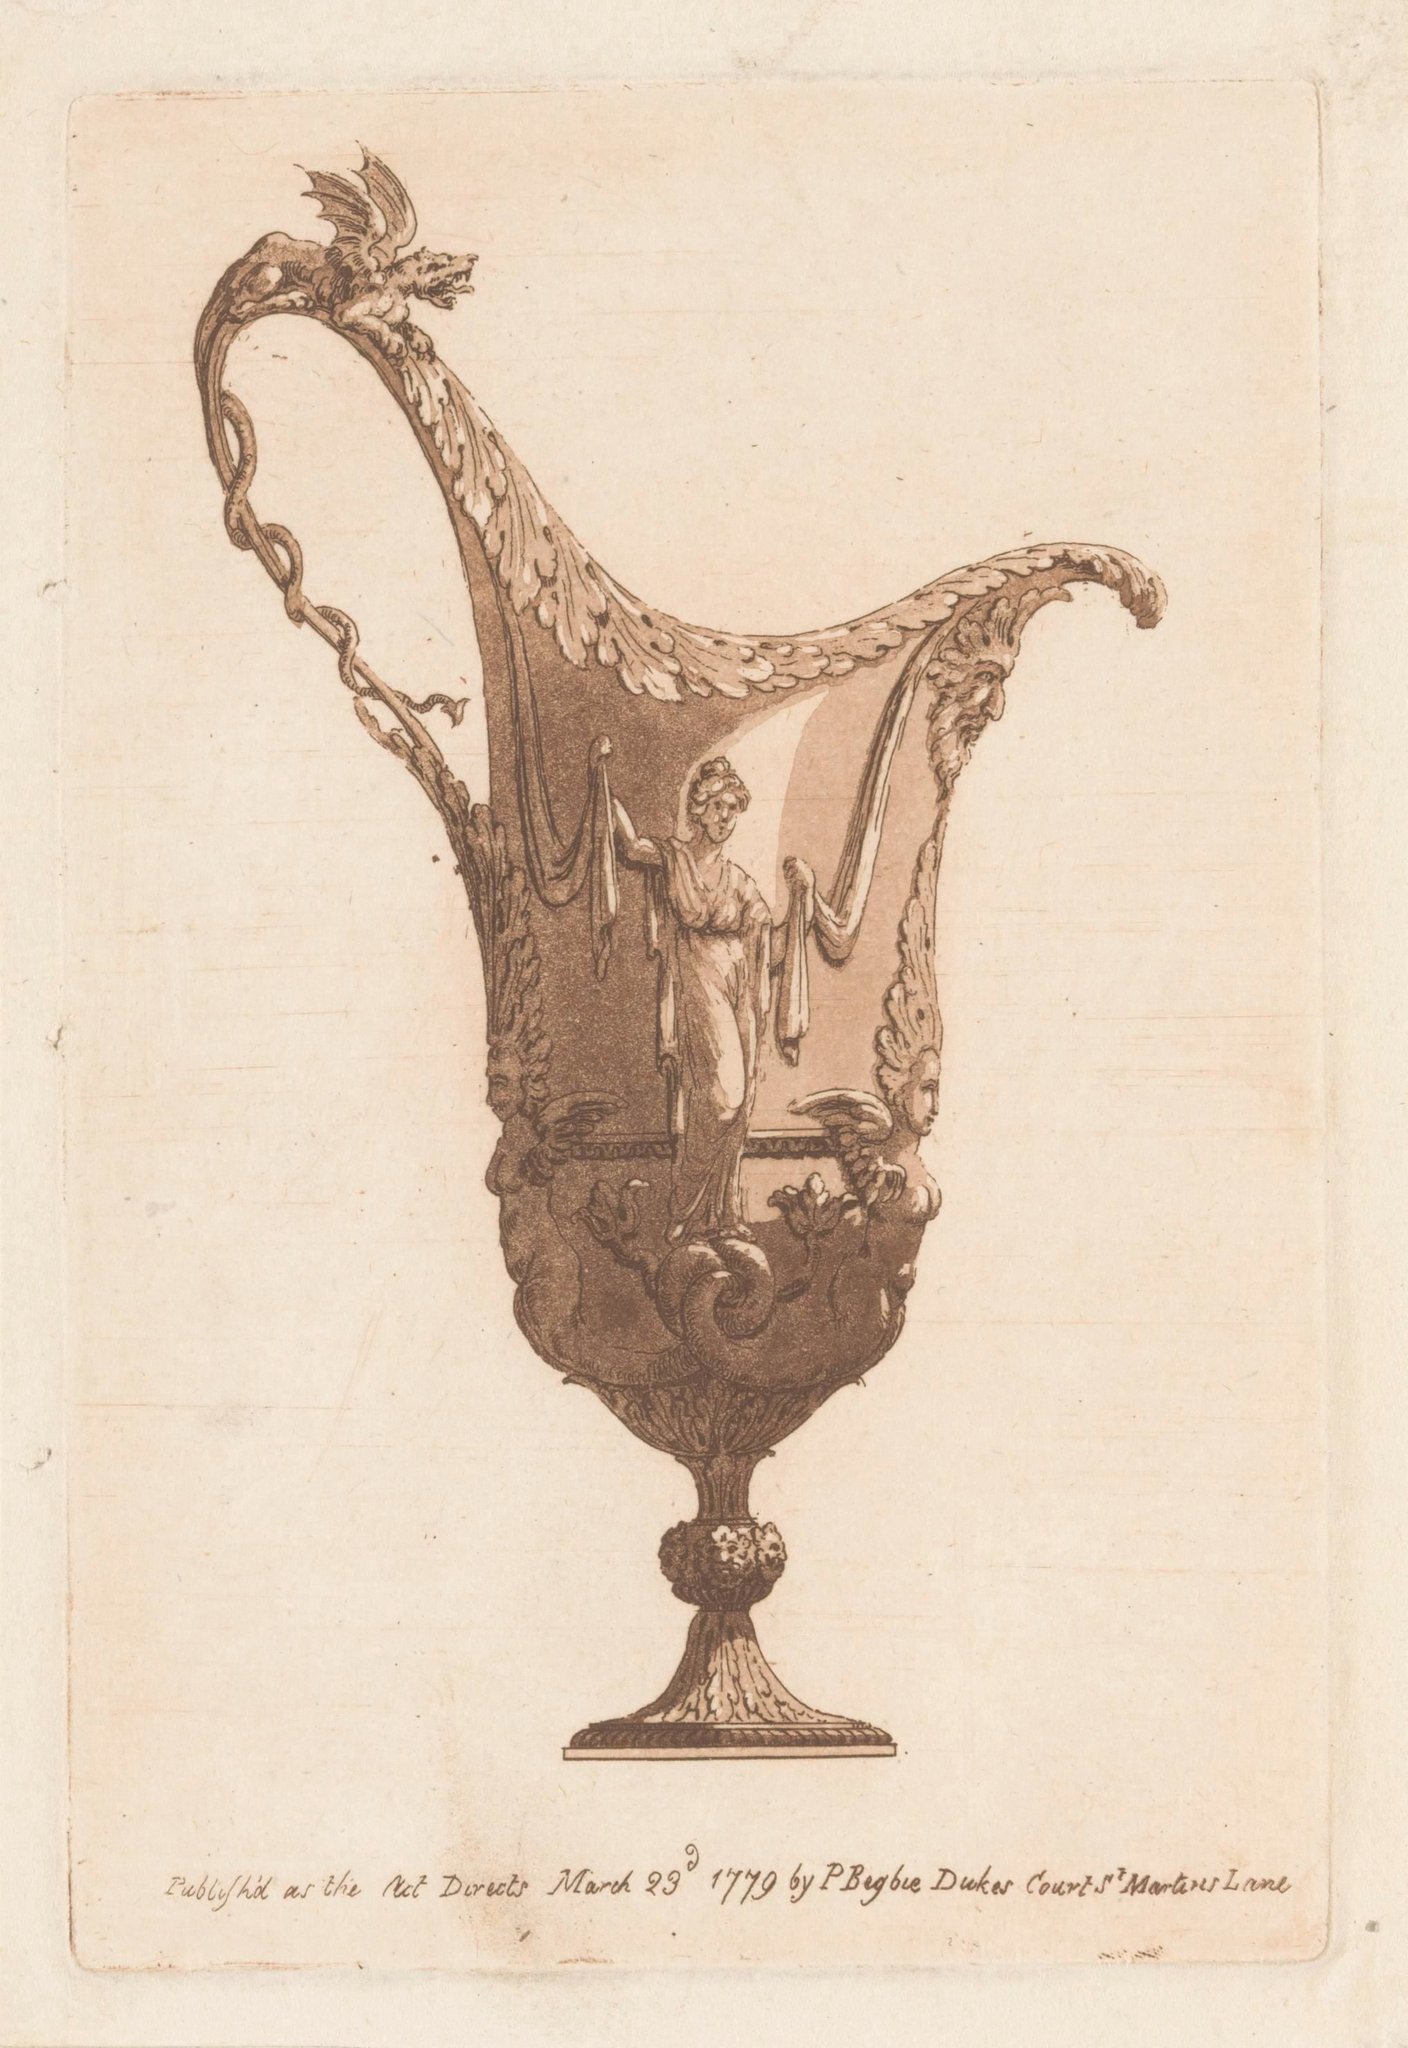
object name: print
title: Antieke kan met staande vrouw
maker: patrick begbie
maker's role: print maker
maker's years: -1820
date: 1779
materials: paper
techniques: aquatint, etching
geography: london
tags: vase ~ ornament, standing figure - aa - female human figure, hangings and drapery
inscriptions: collector's mark: Lugt 2228, collector's mark: Lugt 2760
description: Een antieke geornamenteerde kan met een staande vrouw die draperiëen ophoudt.